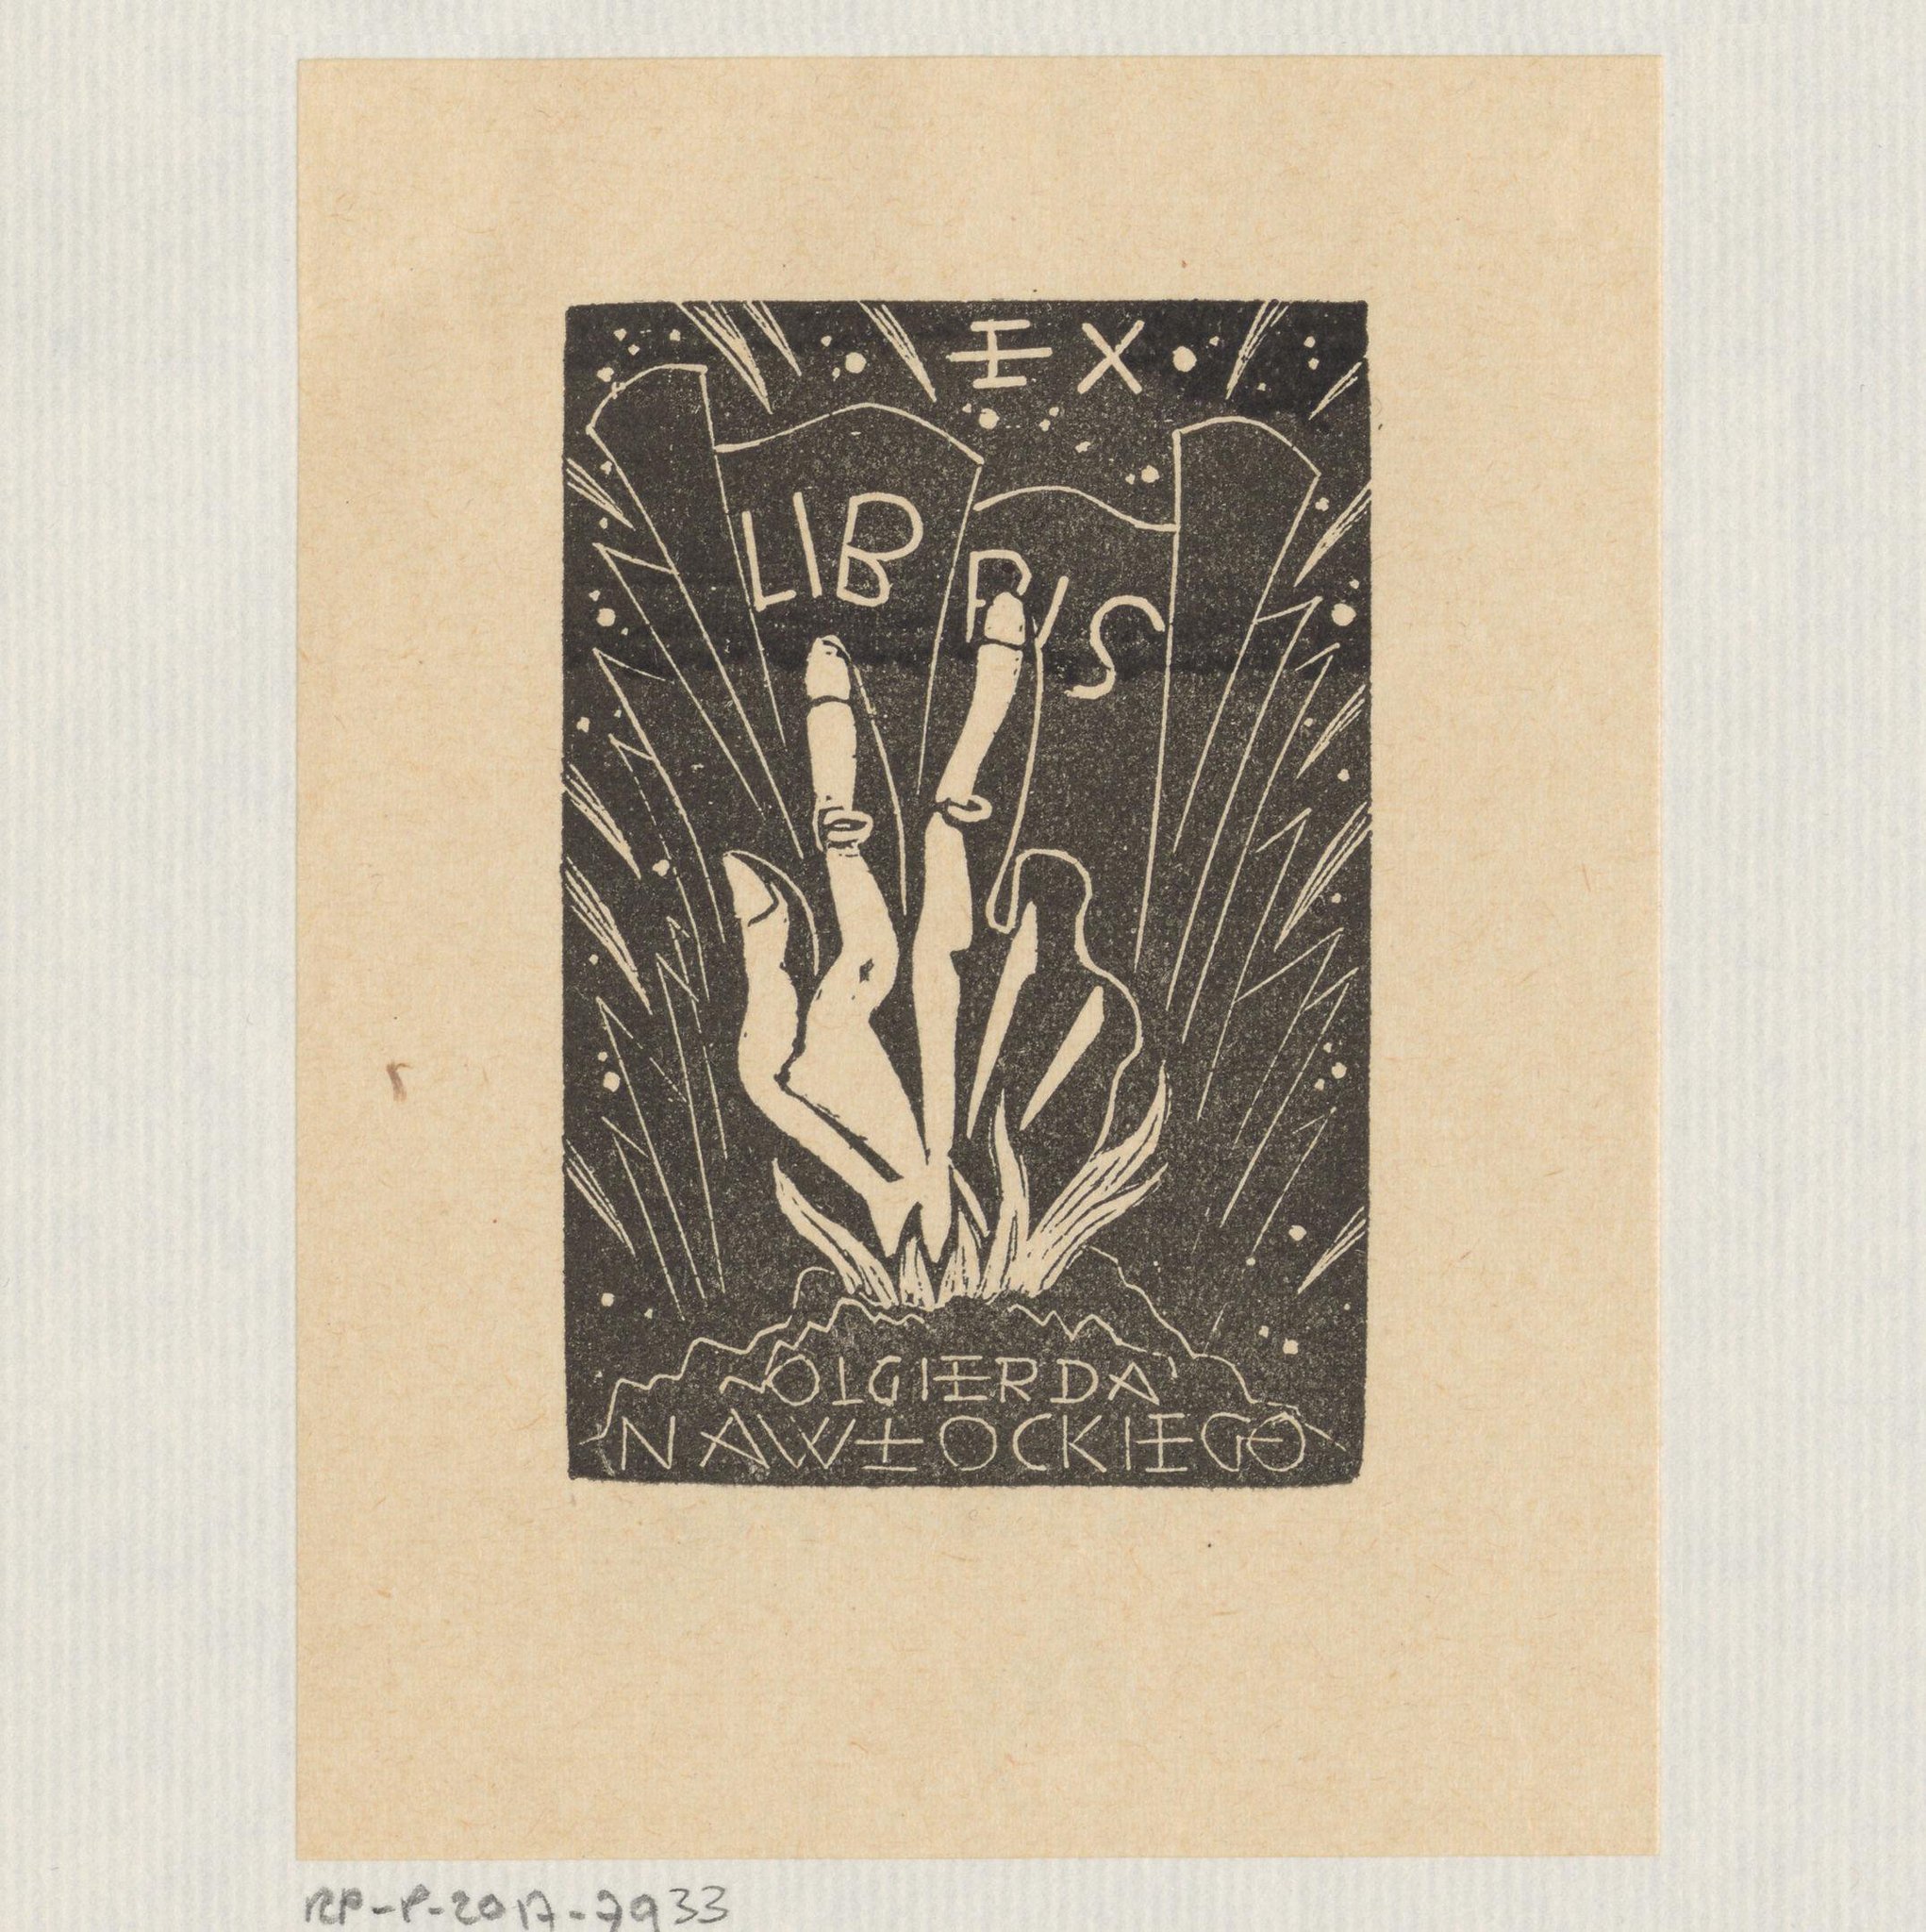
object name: bookplate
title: Ex libris van Olgierd Nawłocki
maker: tadeusz cieślewski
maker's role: print maker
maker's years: 1895-1944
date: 1905-1944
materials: paper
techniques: woodcut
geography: poland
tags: hand